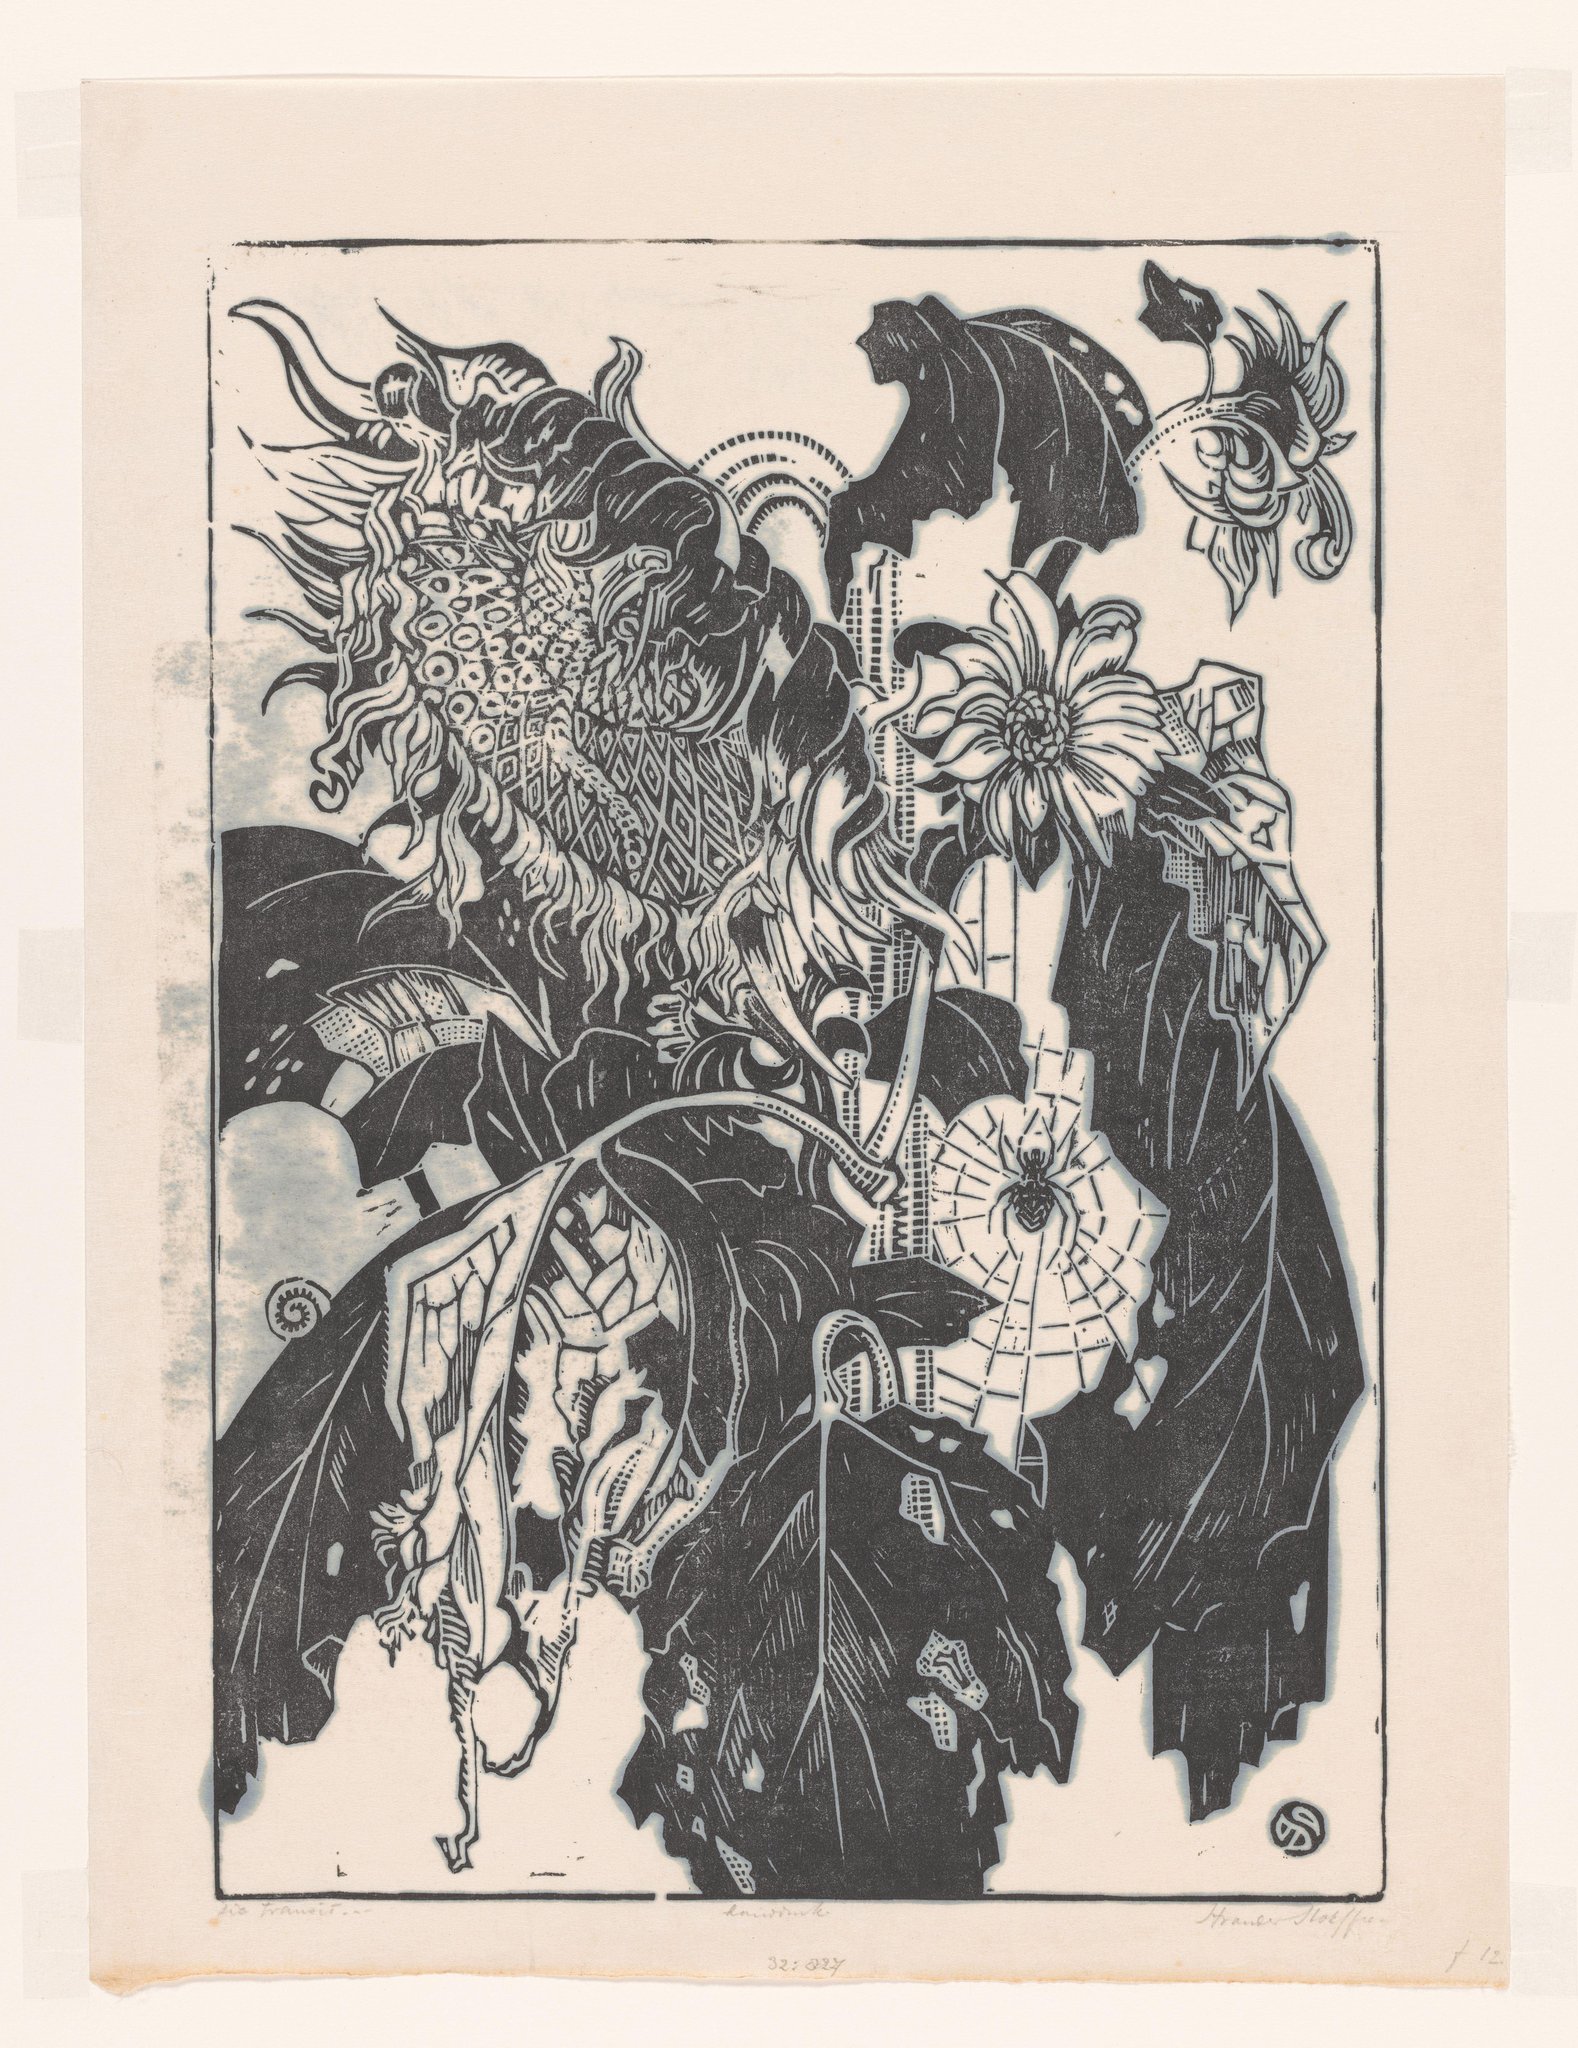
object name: print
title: Sic transit...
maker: henri van der stok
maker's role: print maker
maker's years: 1870-1946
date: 1880-1932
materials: paper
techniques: woodcut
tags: flowers: sunflower, flowers in a vase